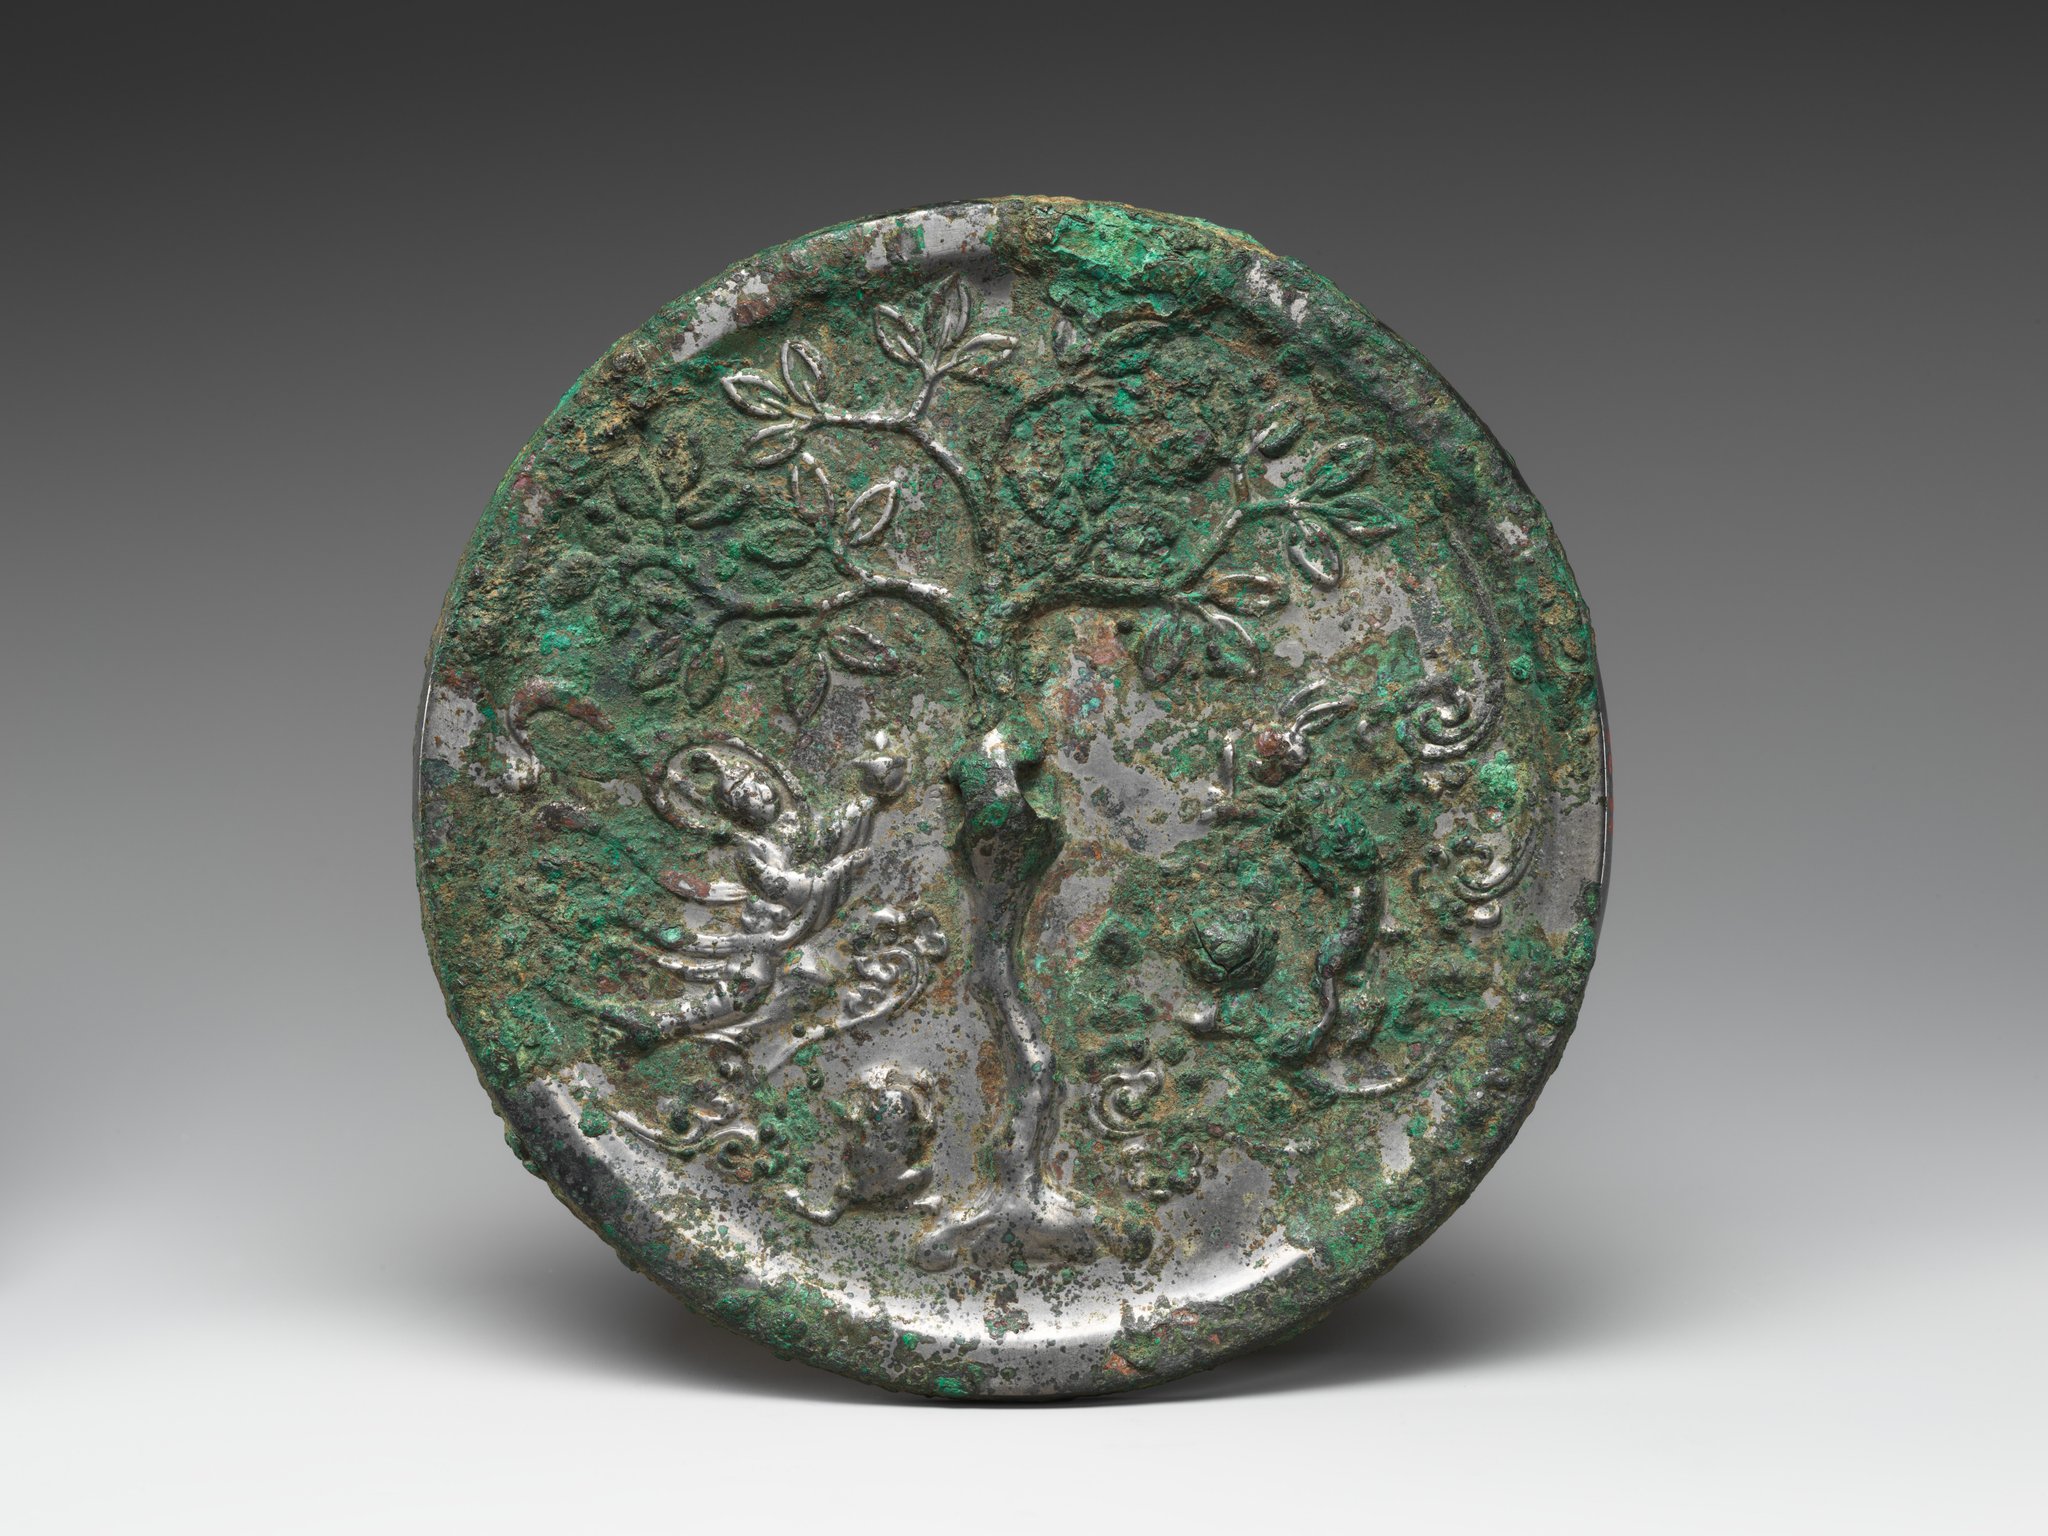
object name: mirror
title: Mirror with moon goddess and rabbit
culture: chinese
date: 701-900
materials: bronze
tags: rabbits,goddess